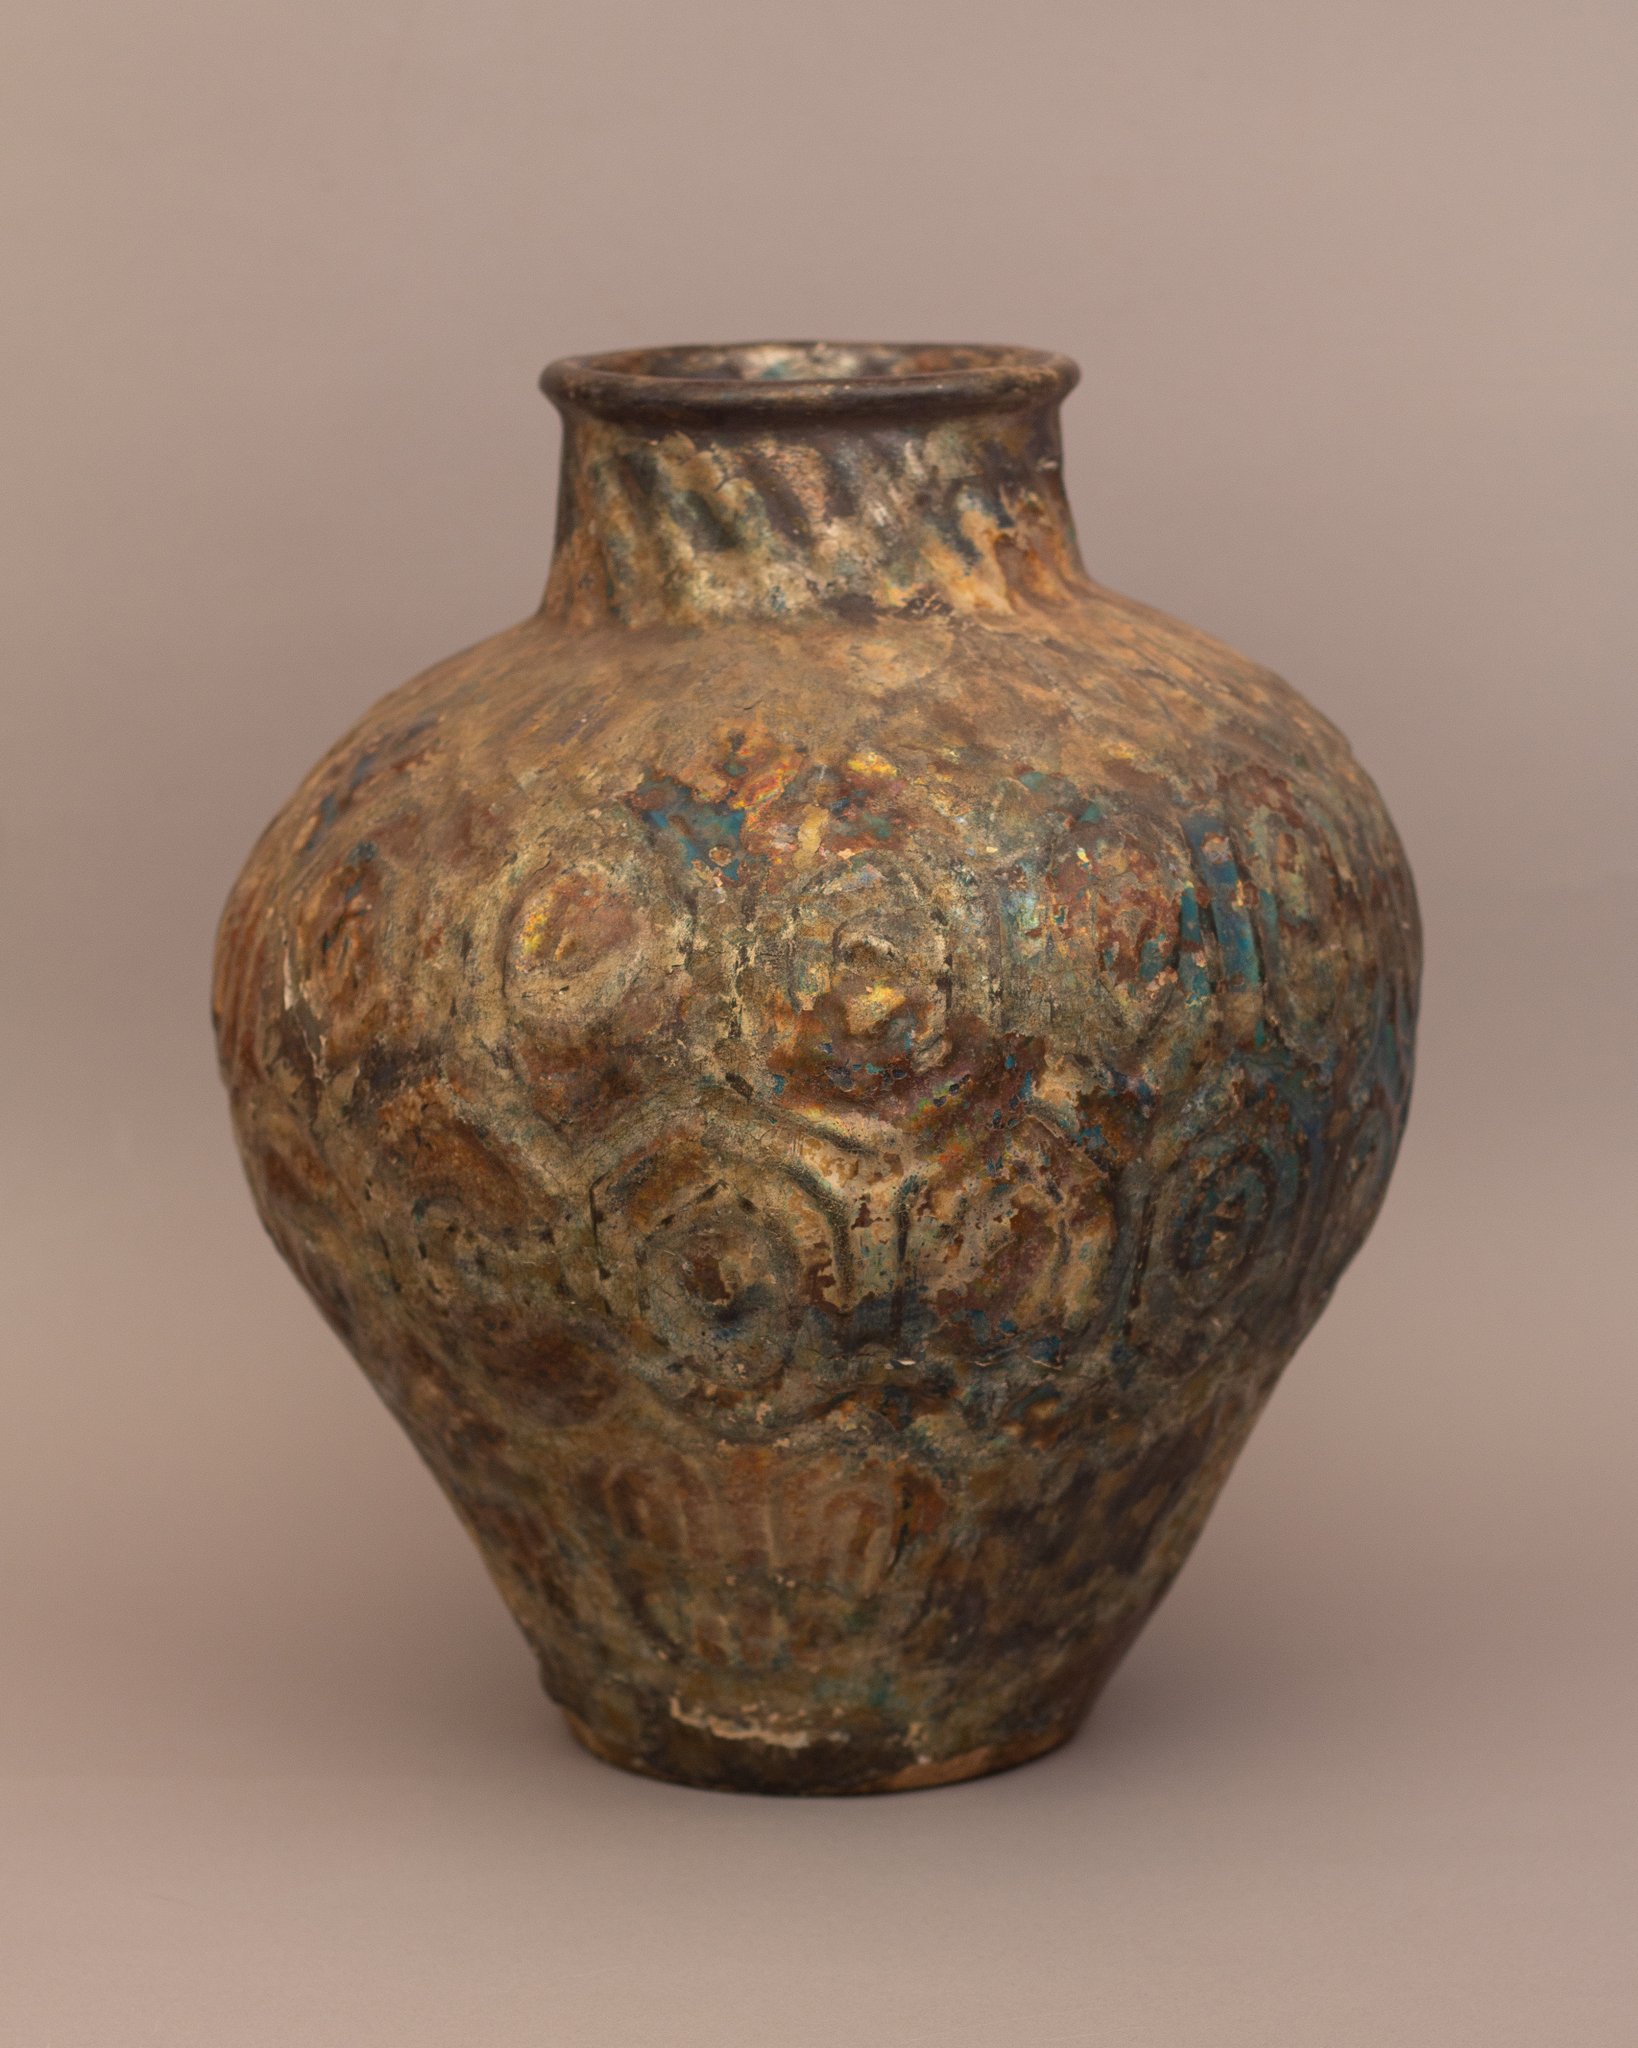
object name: jar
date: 1101-1300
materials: stonepaste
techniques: molding, painting, underglaze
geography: syria